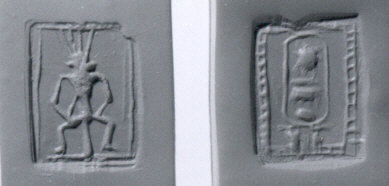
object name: stamp seal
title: Stamp seal: Bes; cartouche of Men-kheper-re (Thutmose III)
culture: egyptian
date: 1479-1425 BCE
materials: stone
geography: egypt or levant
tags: cartouches